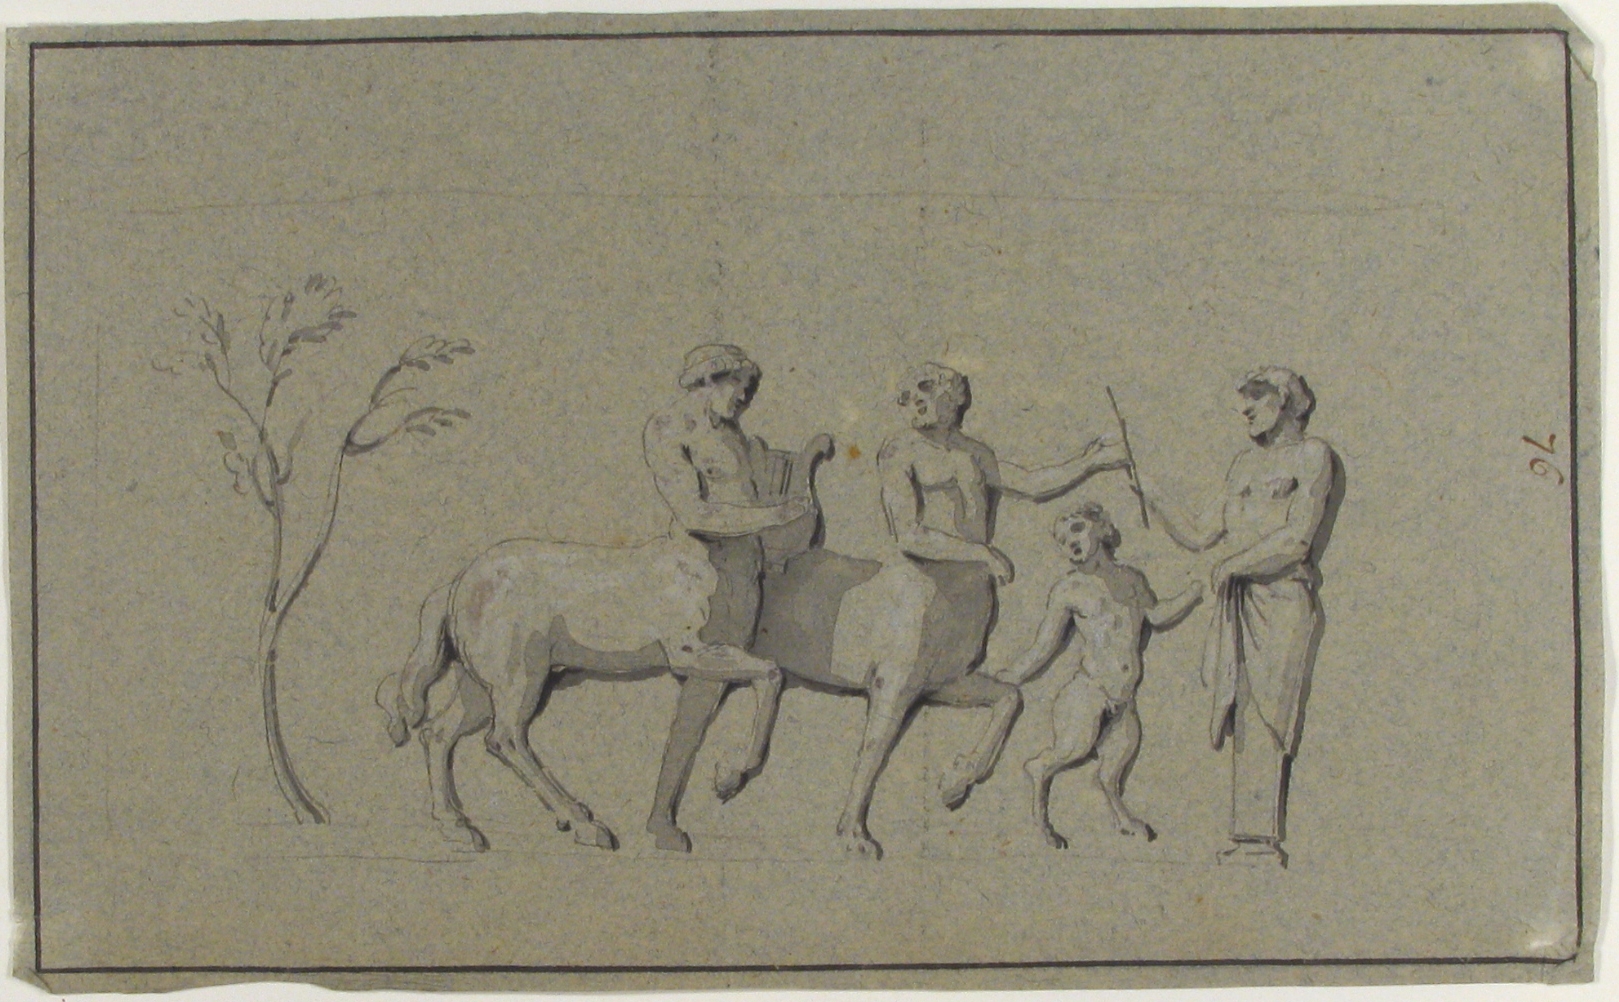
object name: drawing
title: Drawing of Group of Centaurs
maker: anonymous, french, 18th century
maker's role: artist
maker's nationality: french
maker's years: 1700-1800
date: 1701-1800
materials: chalk, paper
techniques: brush, wash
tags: centaurs,satyrs